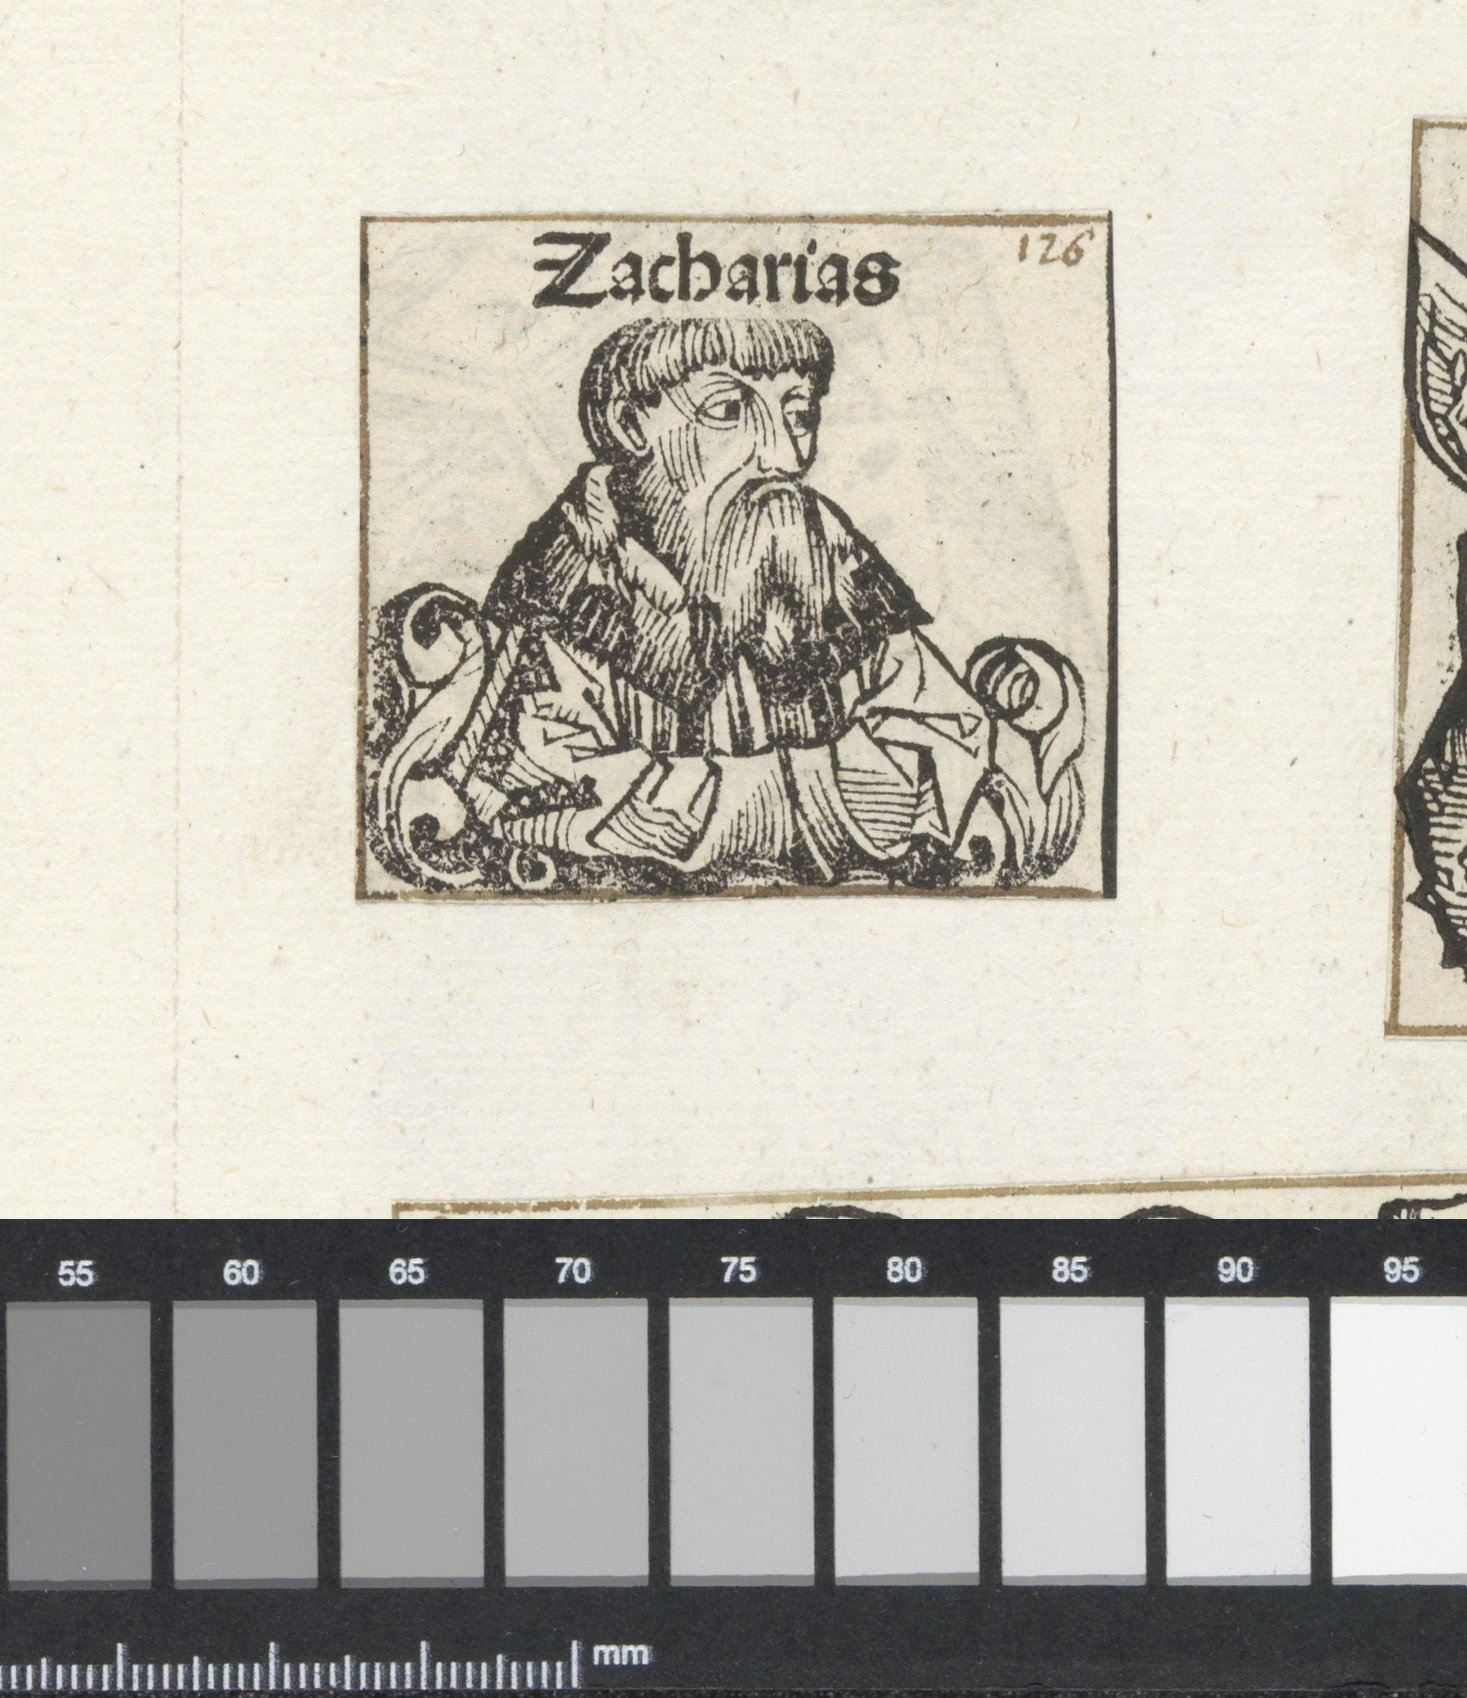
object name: print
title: Zacharia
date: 1493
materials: paper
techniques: letterpress printing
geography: nuremberg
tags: persons from the old testament (not in biblical context, nor occurring in legendary/historical extensions included in division 71)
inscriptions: inscription: ‘126’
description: De houtsnede wordt gebruikt als boekillustratie in de Liber Chronicarum (of Neurenbergkroniek) van Hartmann Schedel, verschenen in het Latijn en Duits in 1493. Zie de Latijnse uitgave, folio 65v.